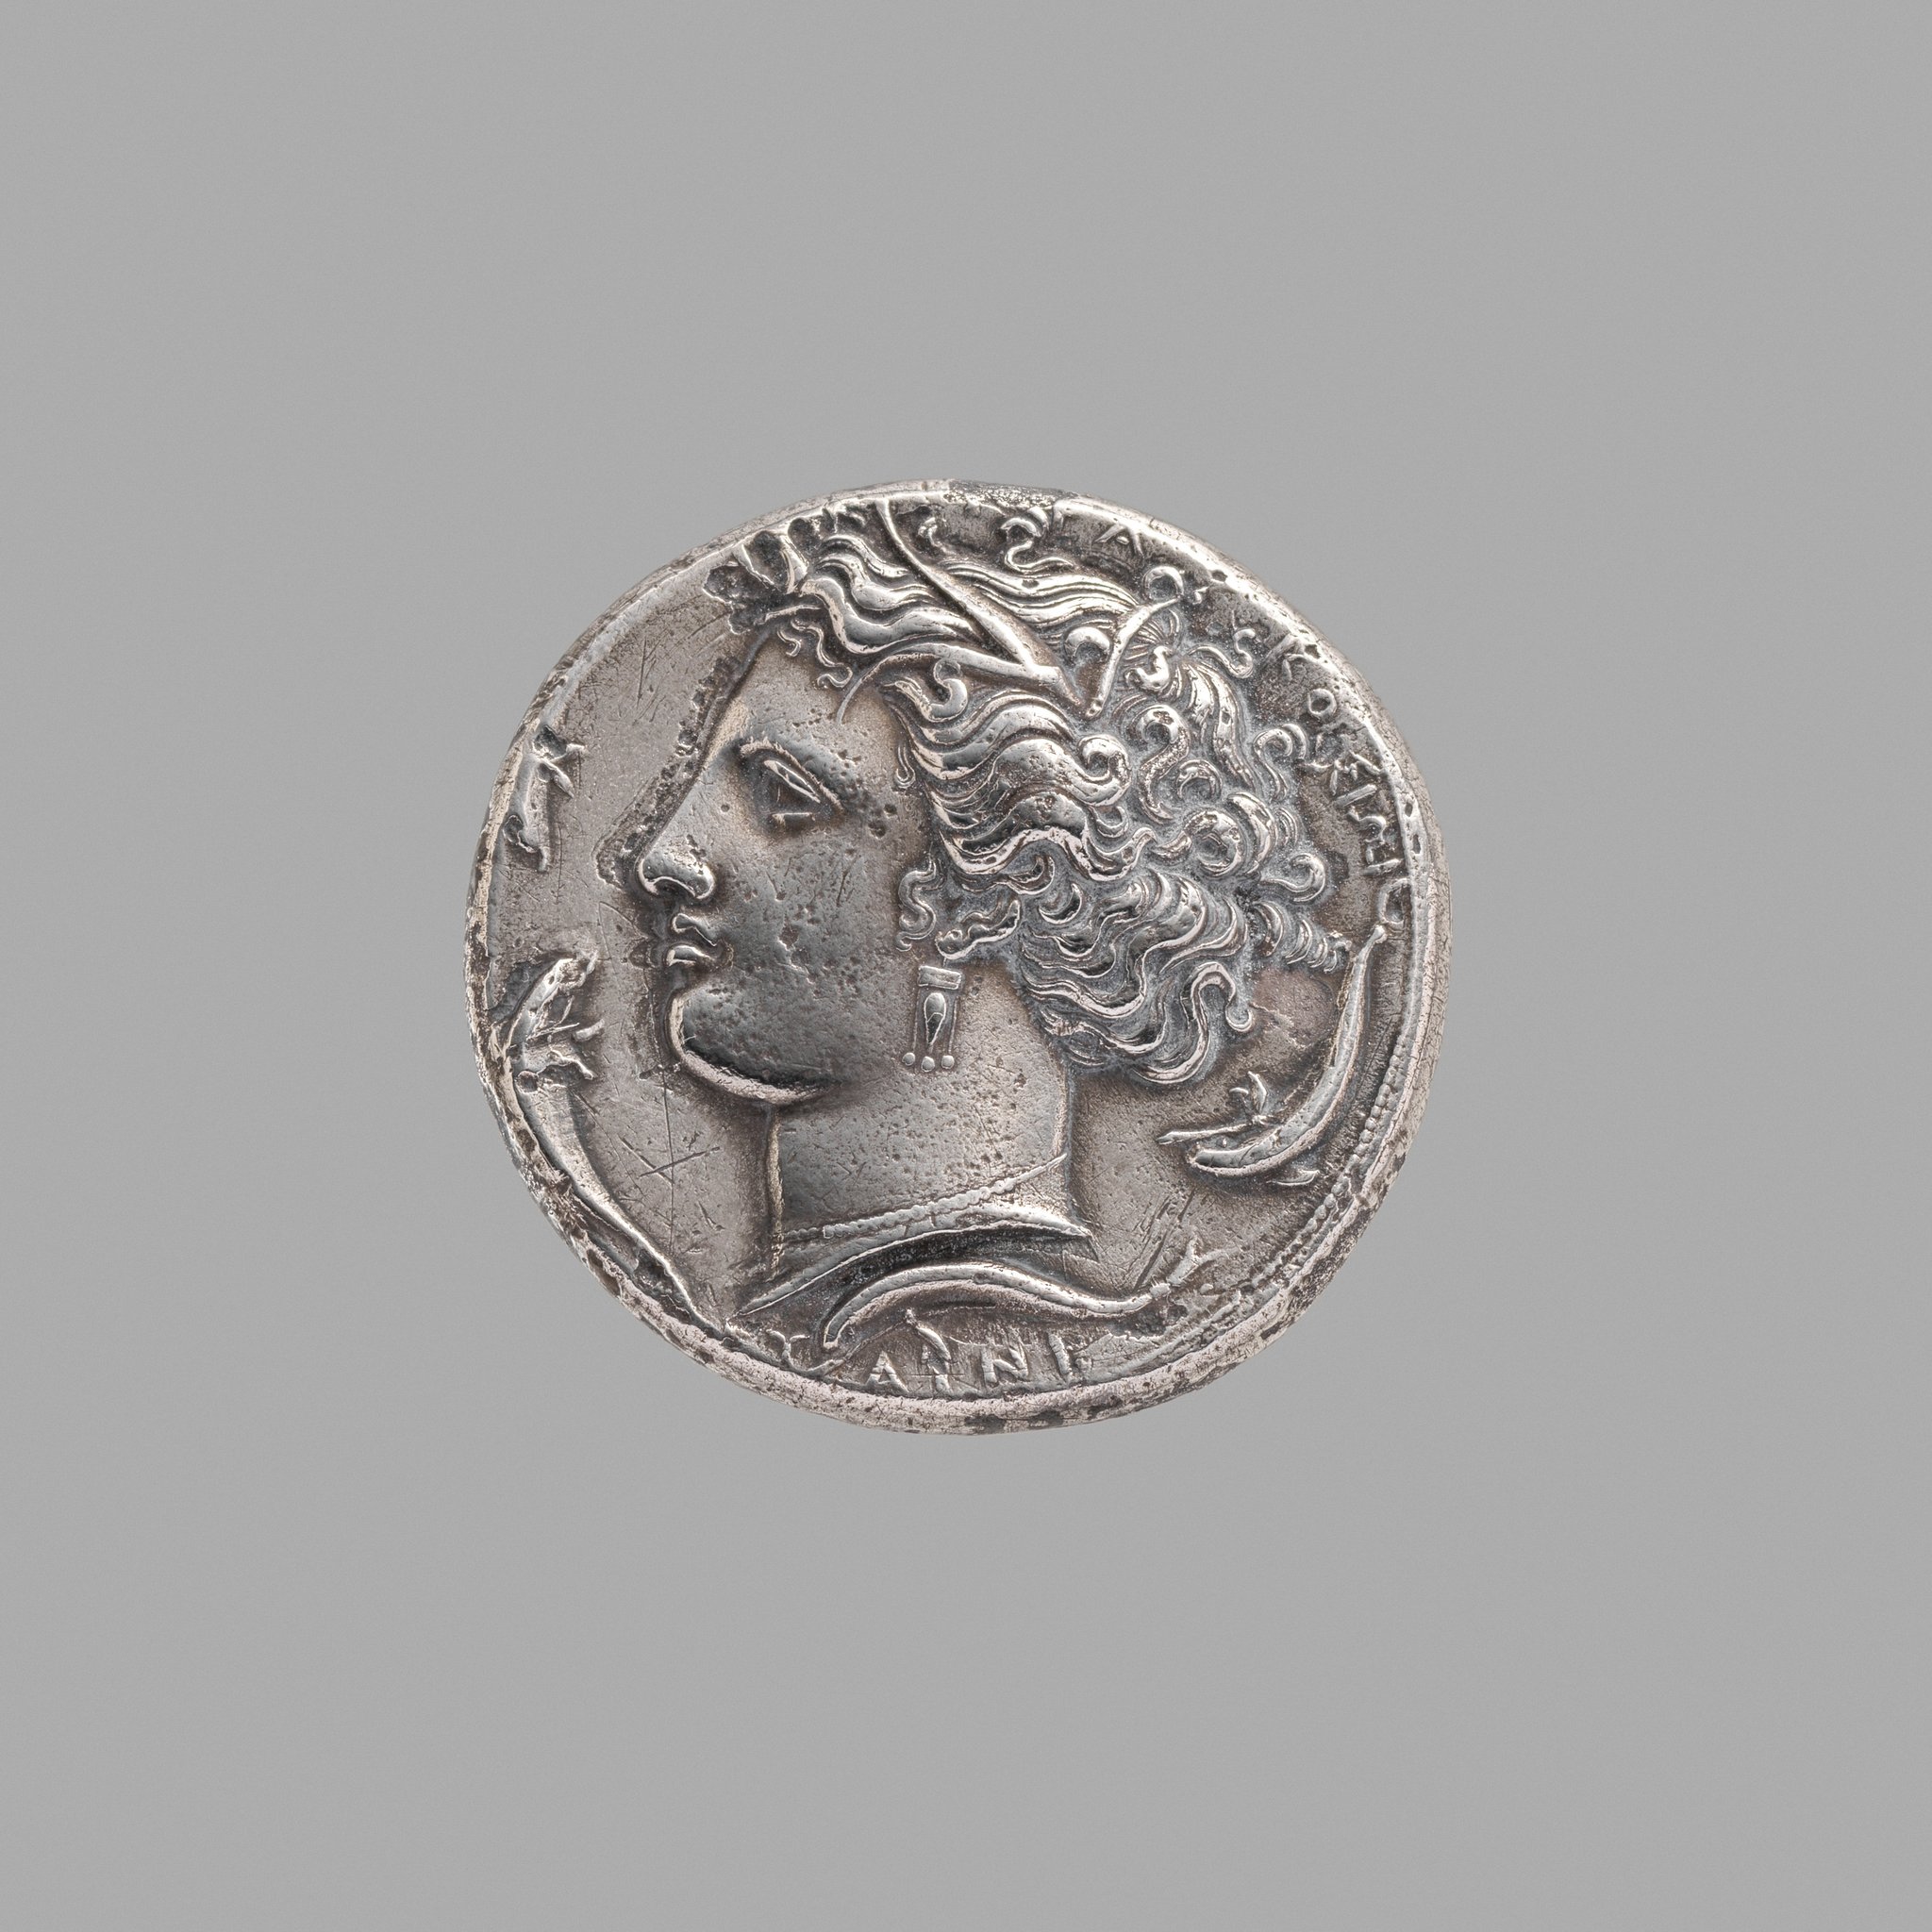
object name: dekadrachm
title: Silver dekadrachm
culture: greek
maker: euainetos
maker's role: artist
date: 400-390 BCE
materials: silver